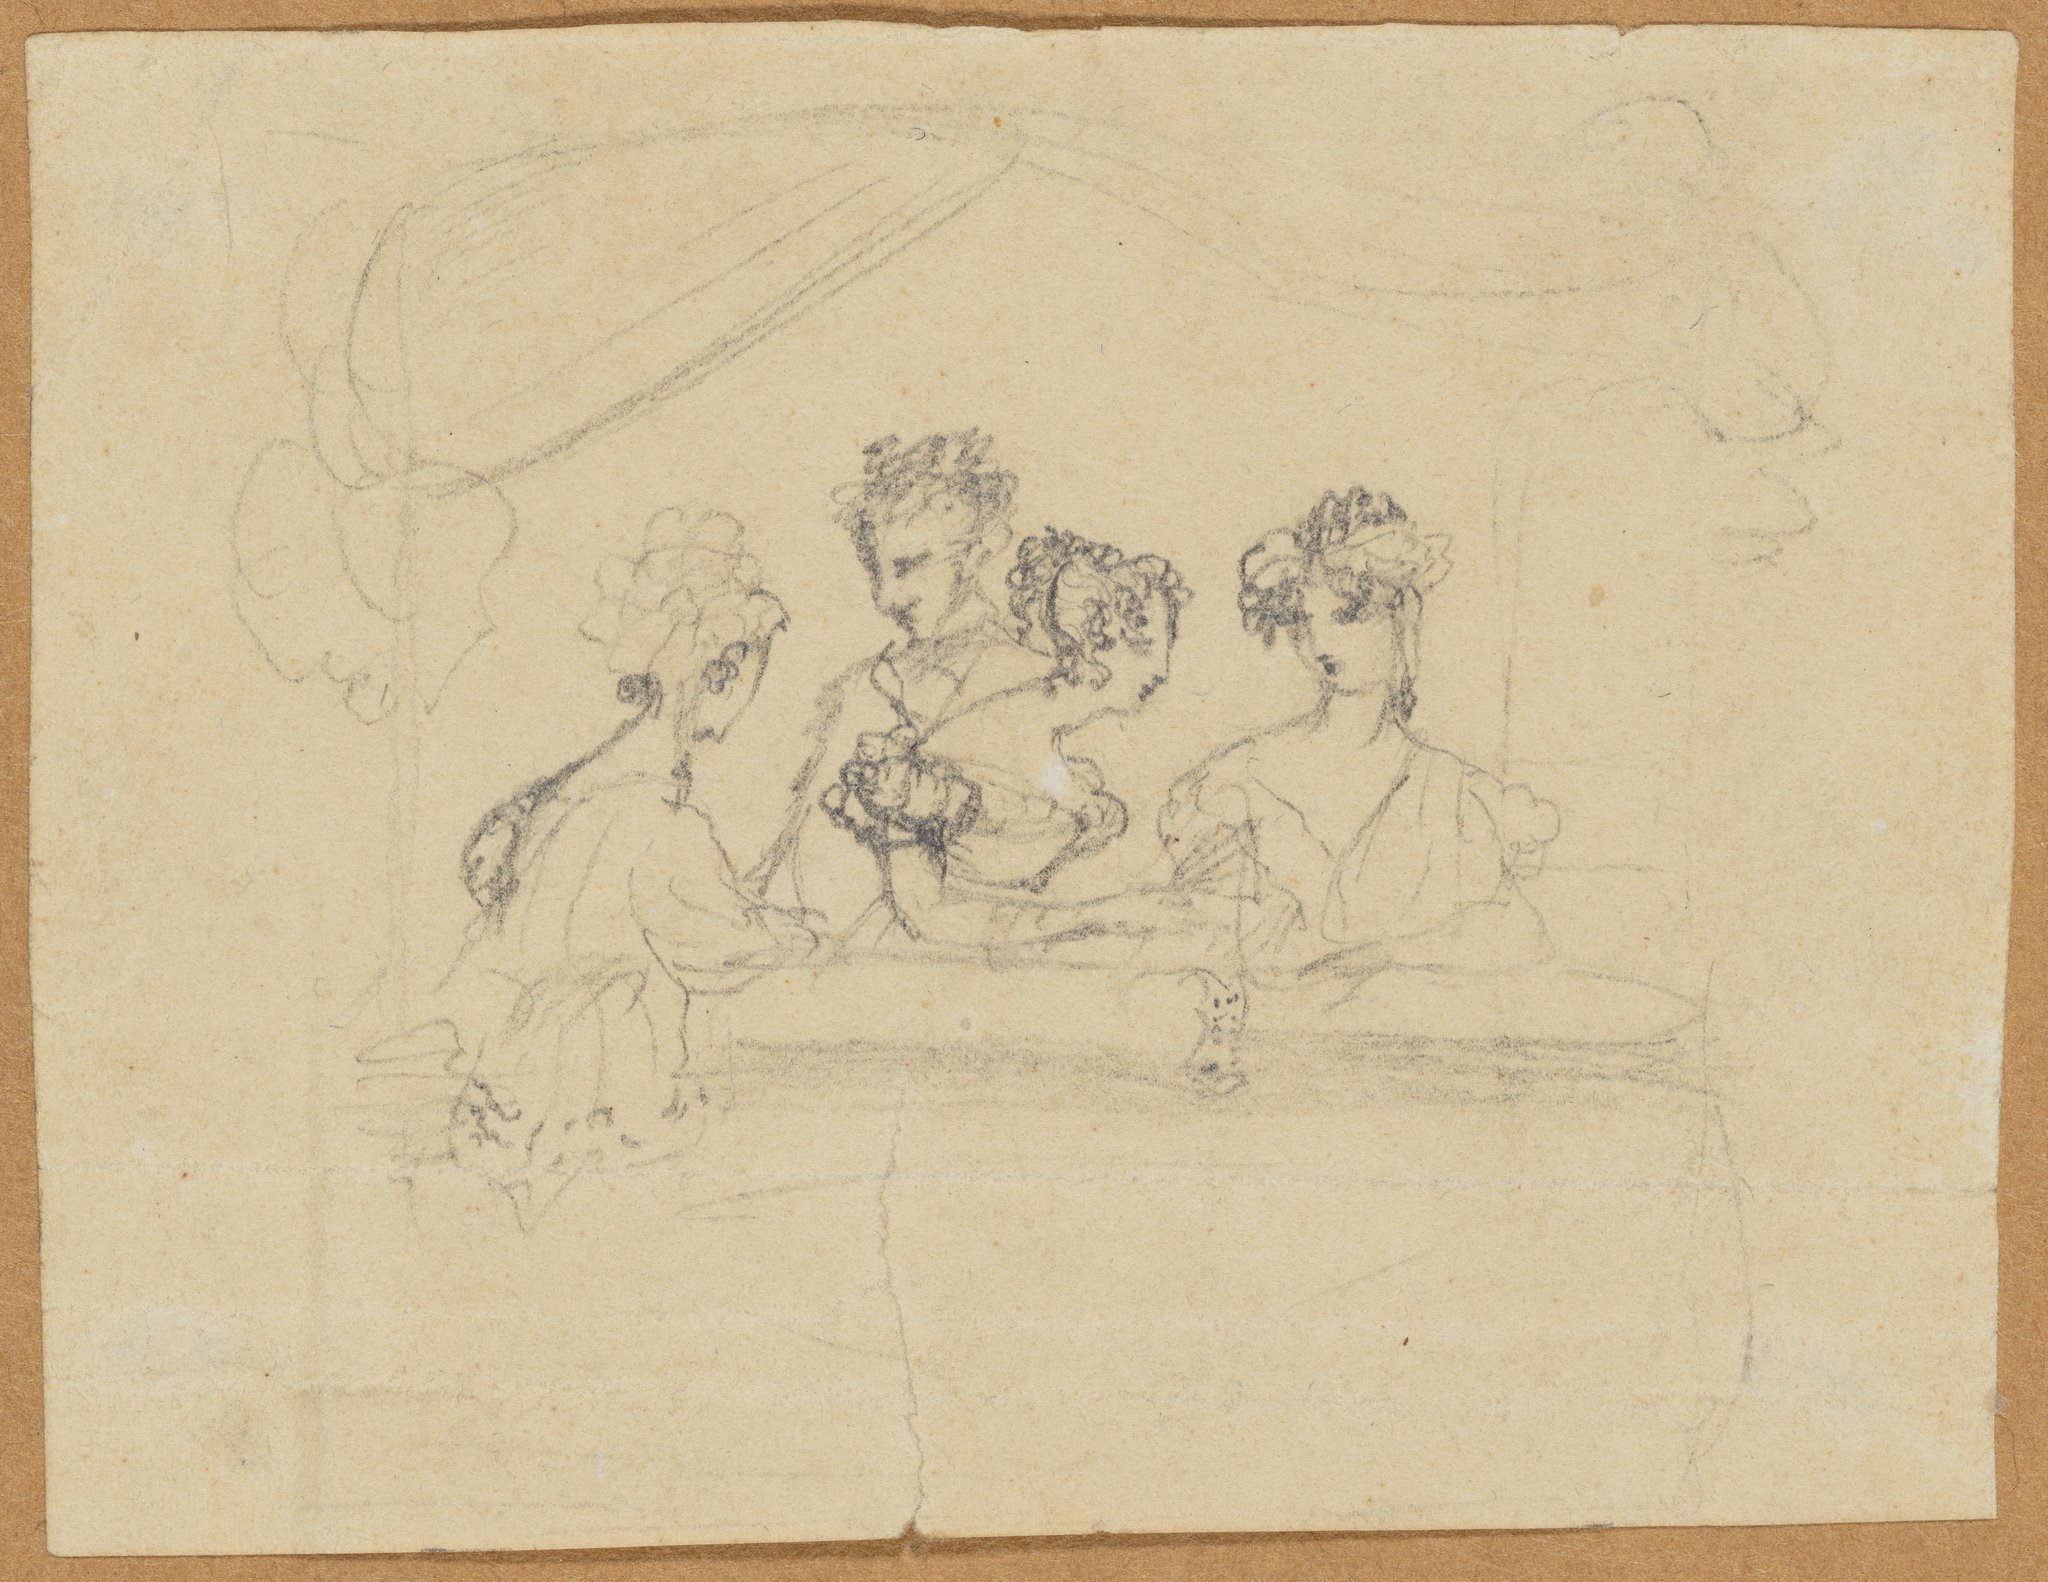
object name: drawing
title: Three Ladies and a Gentleman in a Theater Box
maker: anonymous, british, 19th century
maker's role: artist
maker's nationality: british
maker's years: 1800-1900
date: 1828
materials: graphite